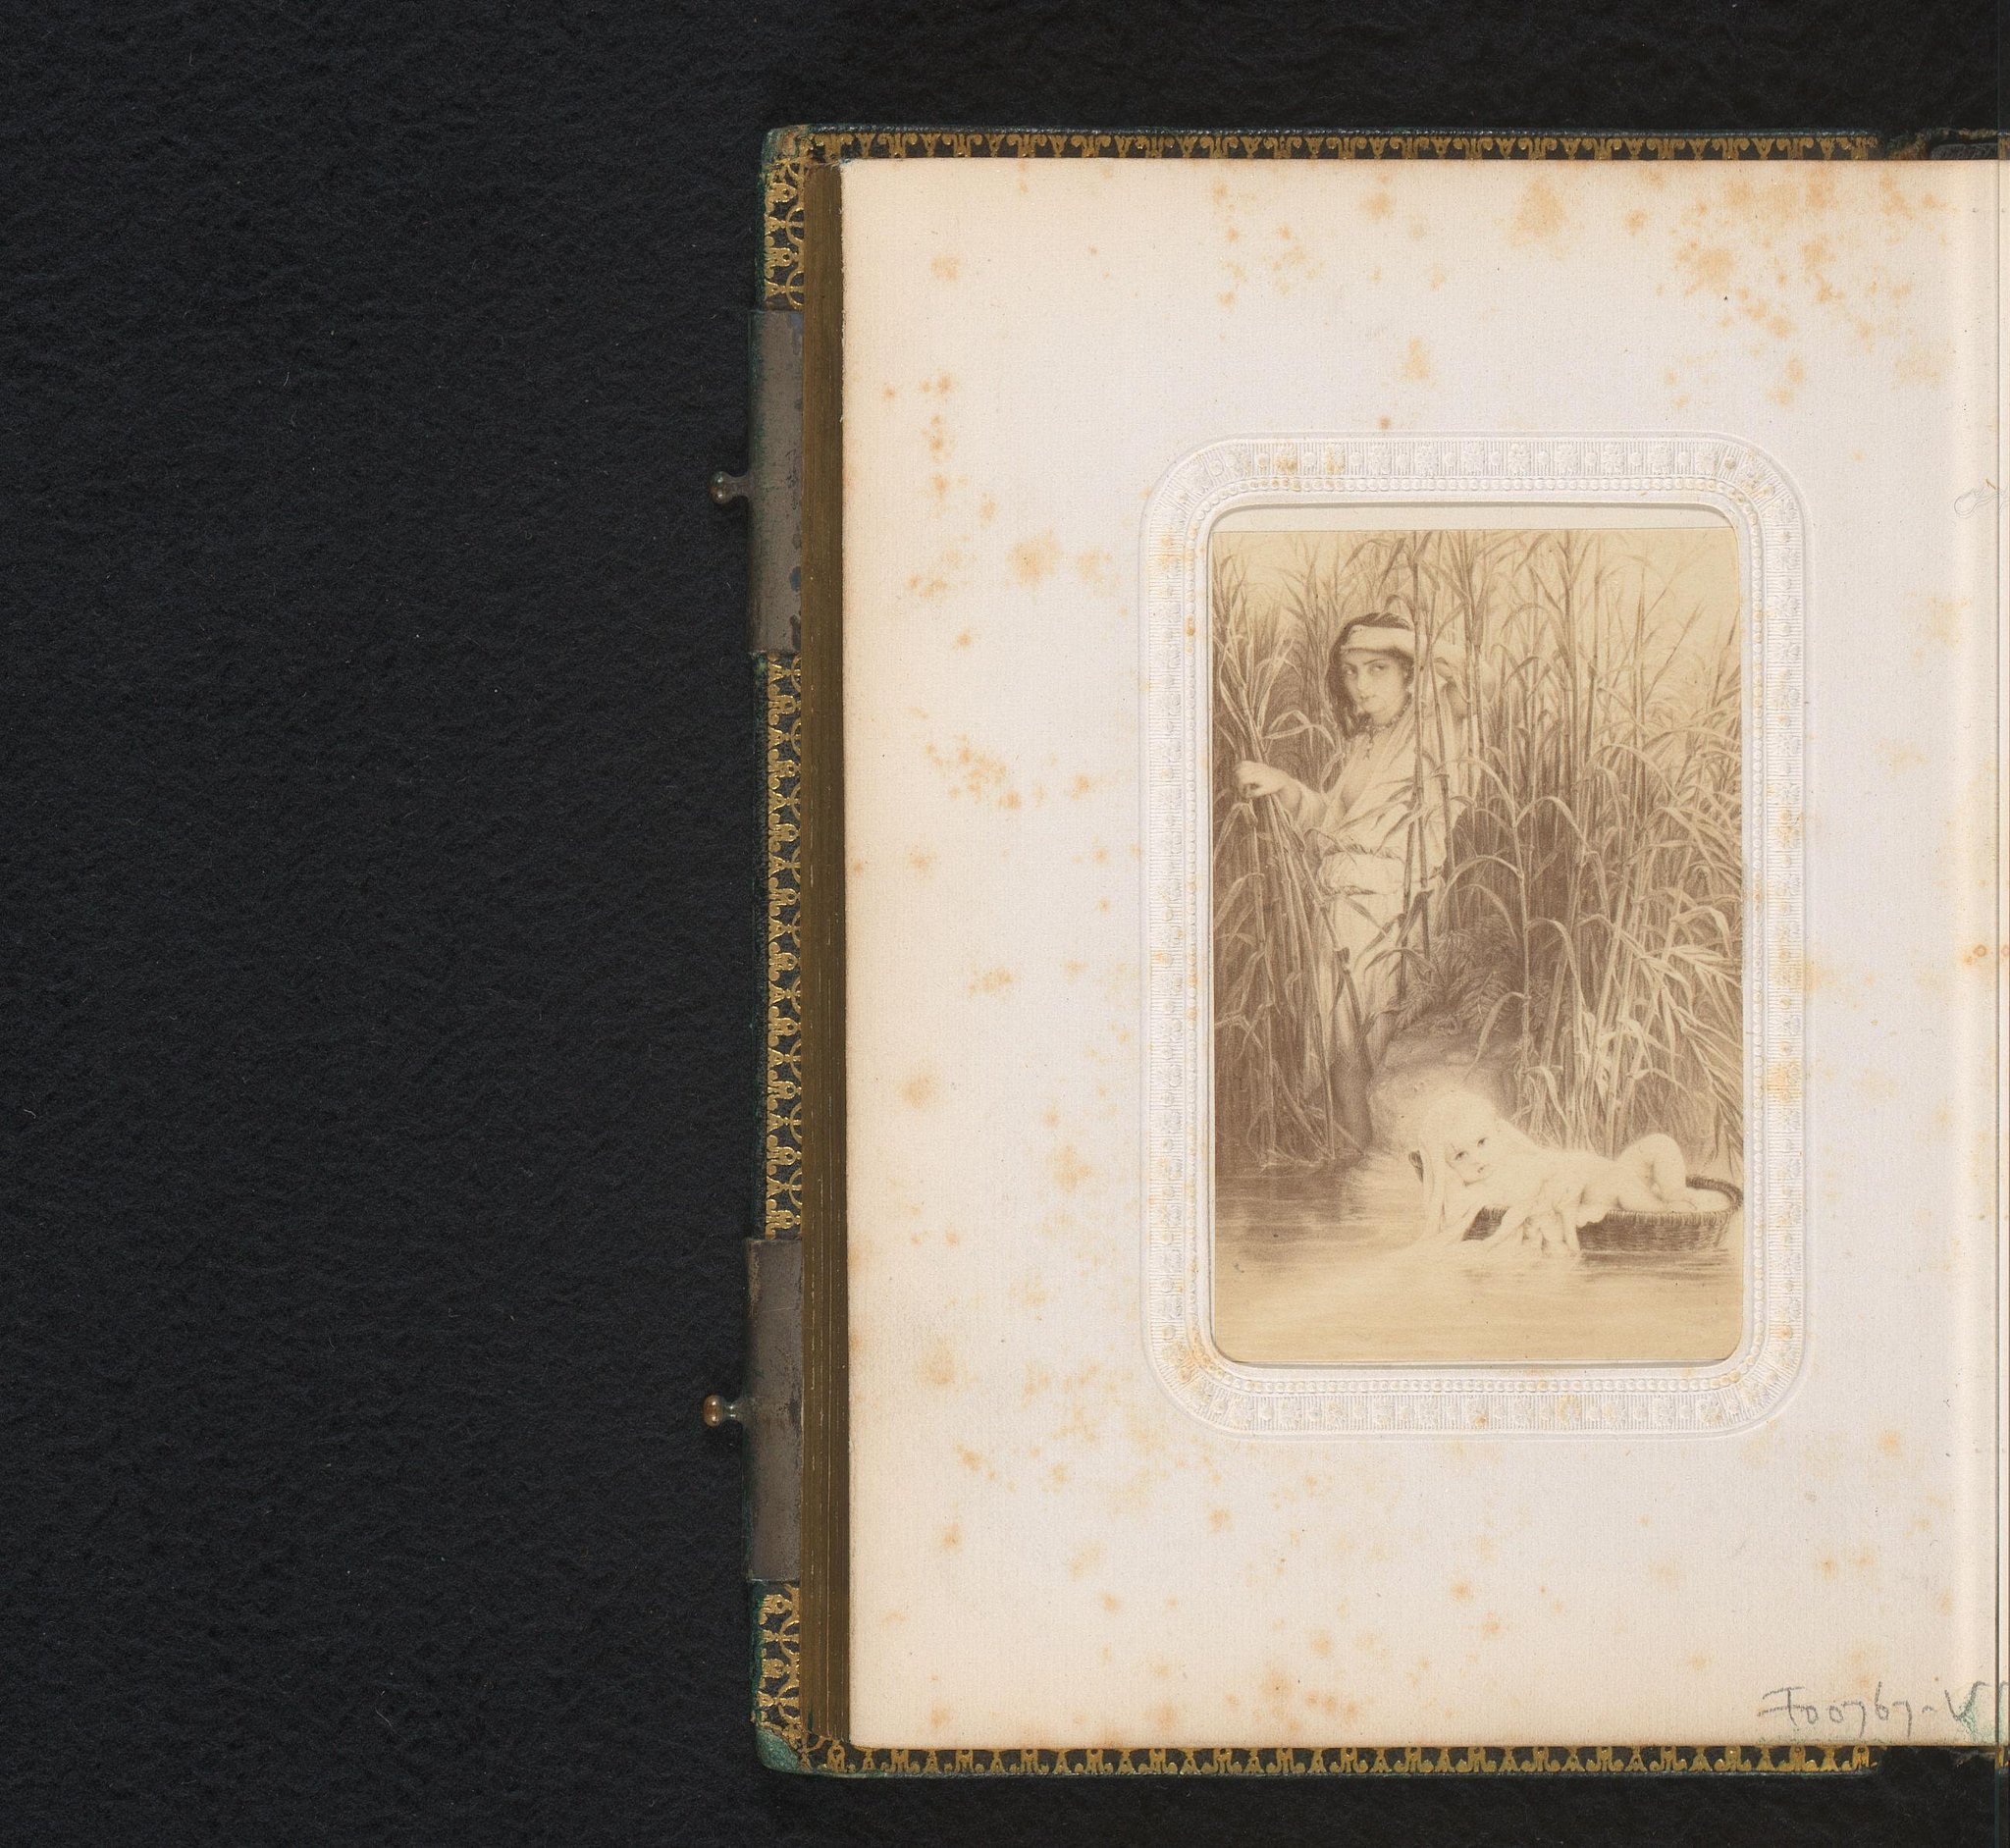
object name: carte de visite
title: Fotoreproductie van een schilderij van Mozes in een mand op de Nijl door Paul Delaroche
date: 1861-1878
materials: cardboard, photographic support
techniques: albumen print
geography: paris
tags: 71e1123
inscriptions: inscription: ‘PHOTOGRAPHIE GOUPIL & Cie/ PARIS, 19, Bd Montmartre./ LONDRES-LA HAYE-BERLIN-NEW YORK’